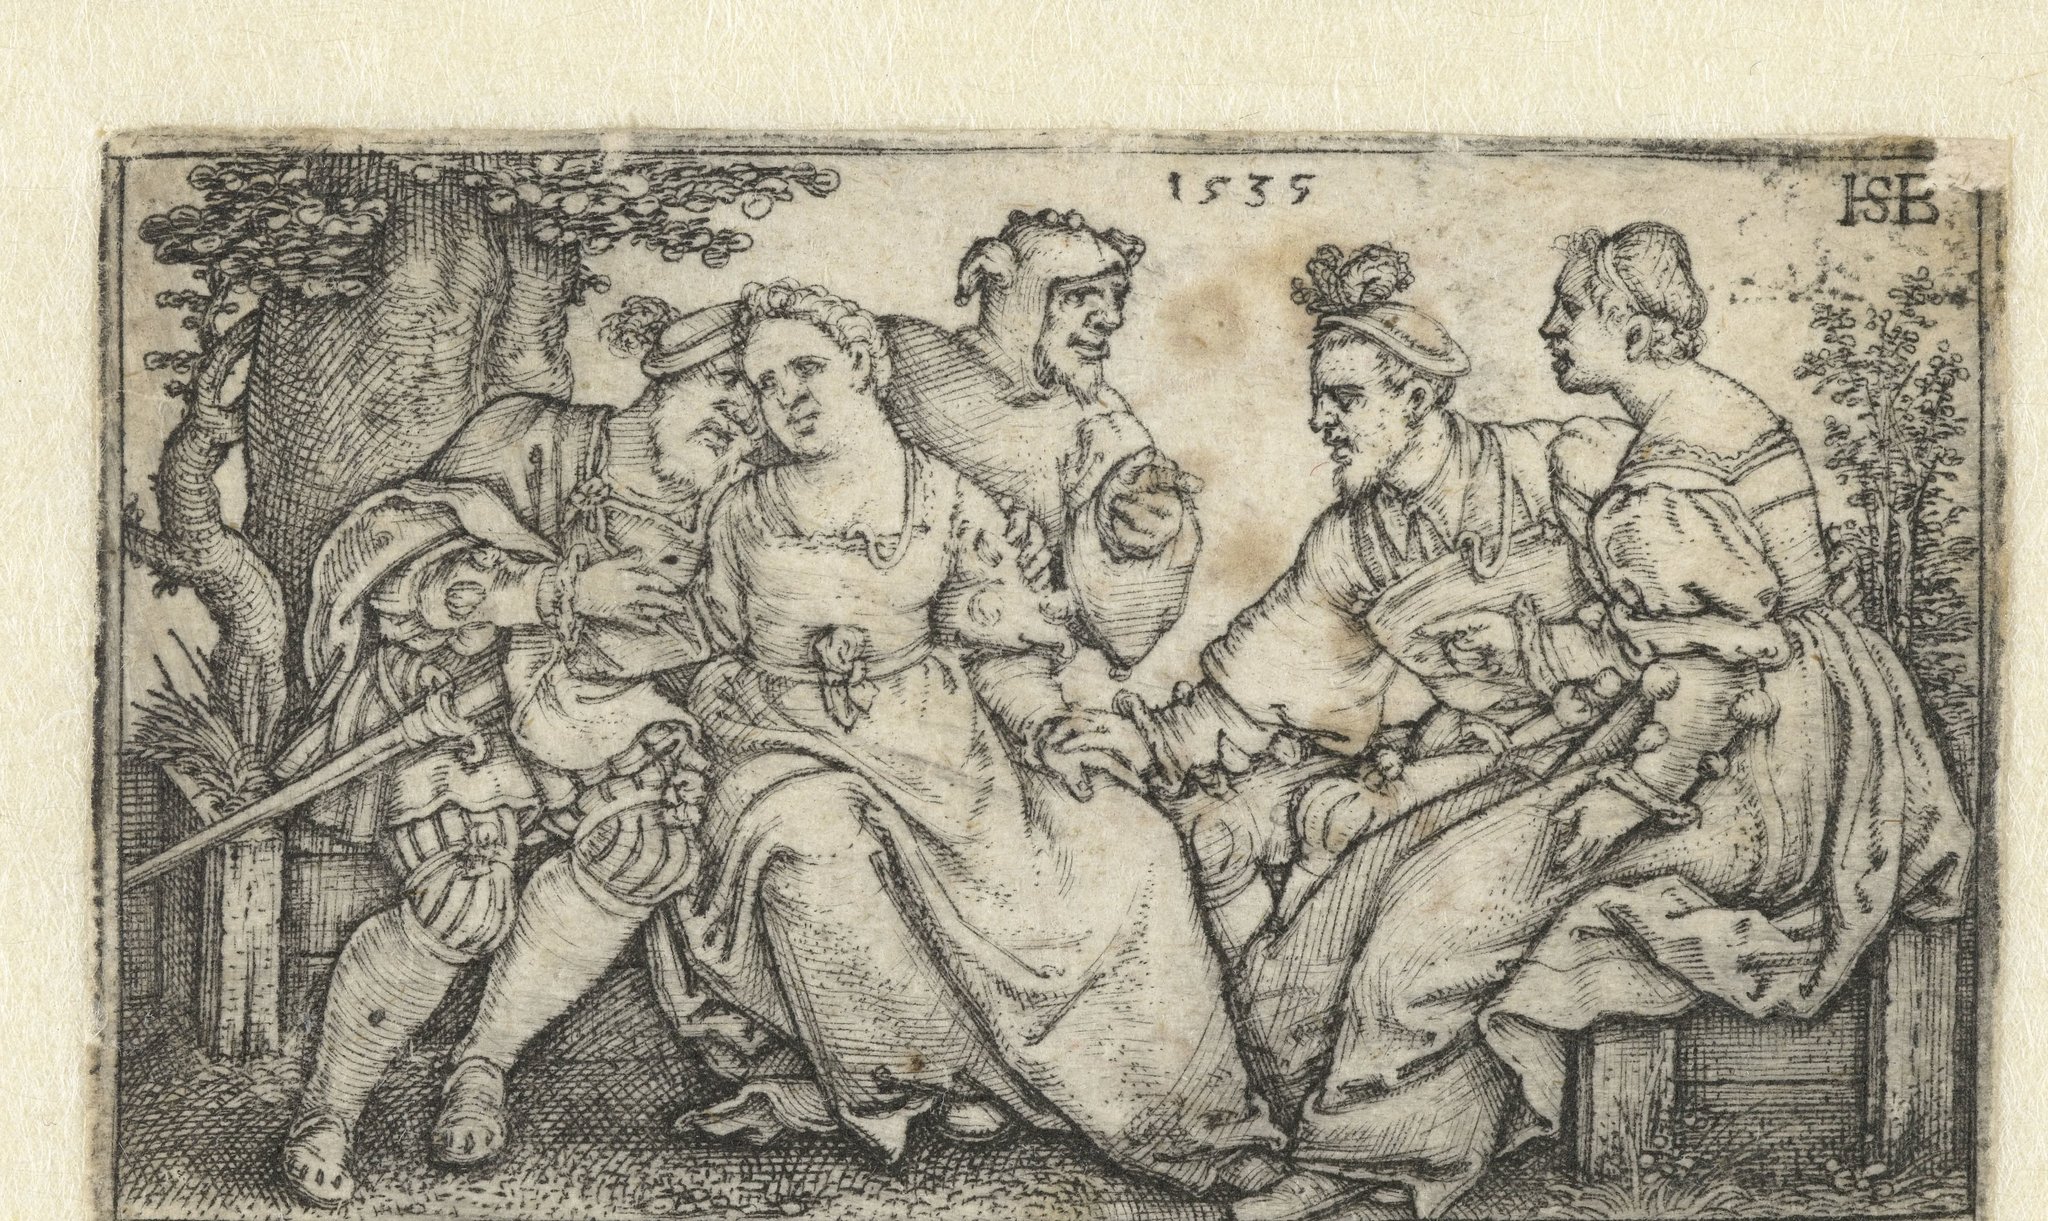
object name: print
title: Twee liefdesparen en een nar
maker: hans sebald beham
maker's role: designer, draughtsman, print maker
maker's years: 1500-1550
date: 1535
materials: paper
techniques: engraving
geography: frankfurt am main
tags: buffoon (in general) (german: 'schalksnarr'), lovers; courting, flirting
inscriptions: collector's mark: Lugt 240